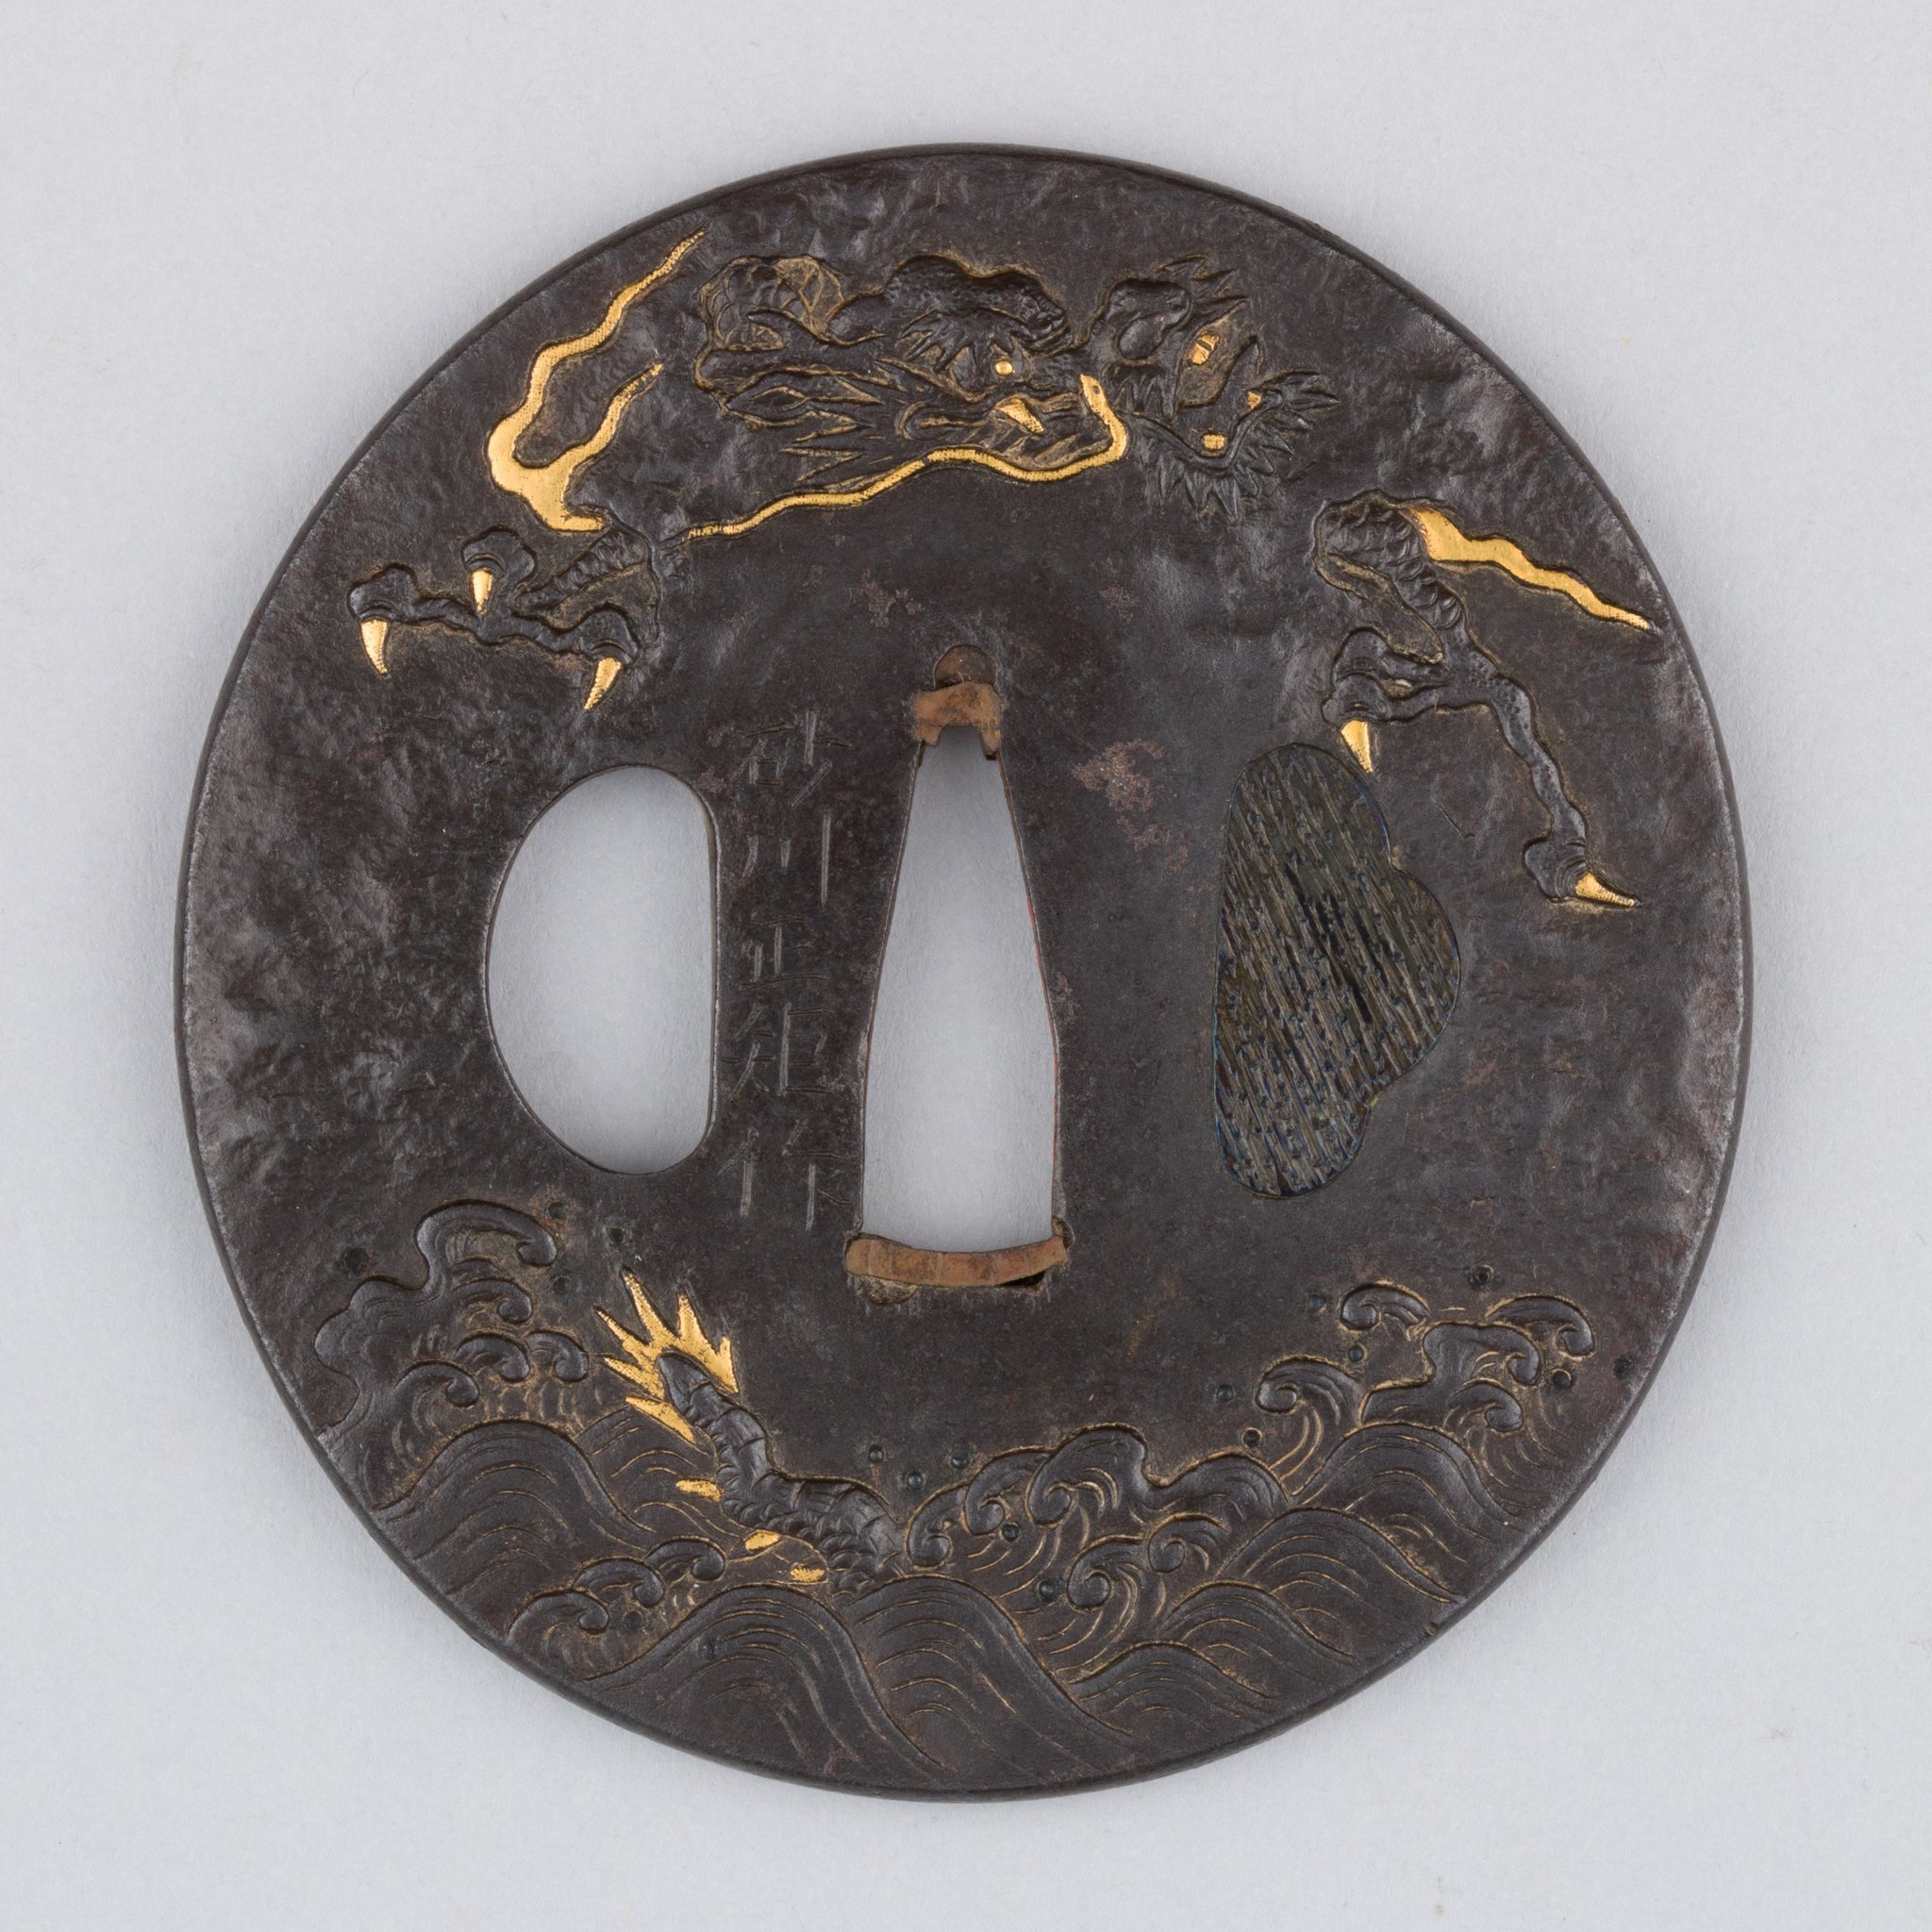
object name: sword guard tsuba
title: Sword Guard (Tsuba)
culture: japanese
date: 1601-1700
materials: copper, silver alloy, gold, iron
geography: japan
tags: dragons